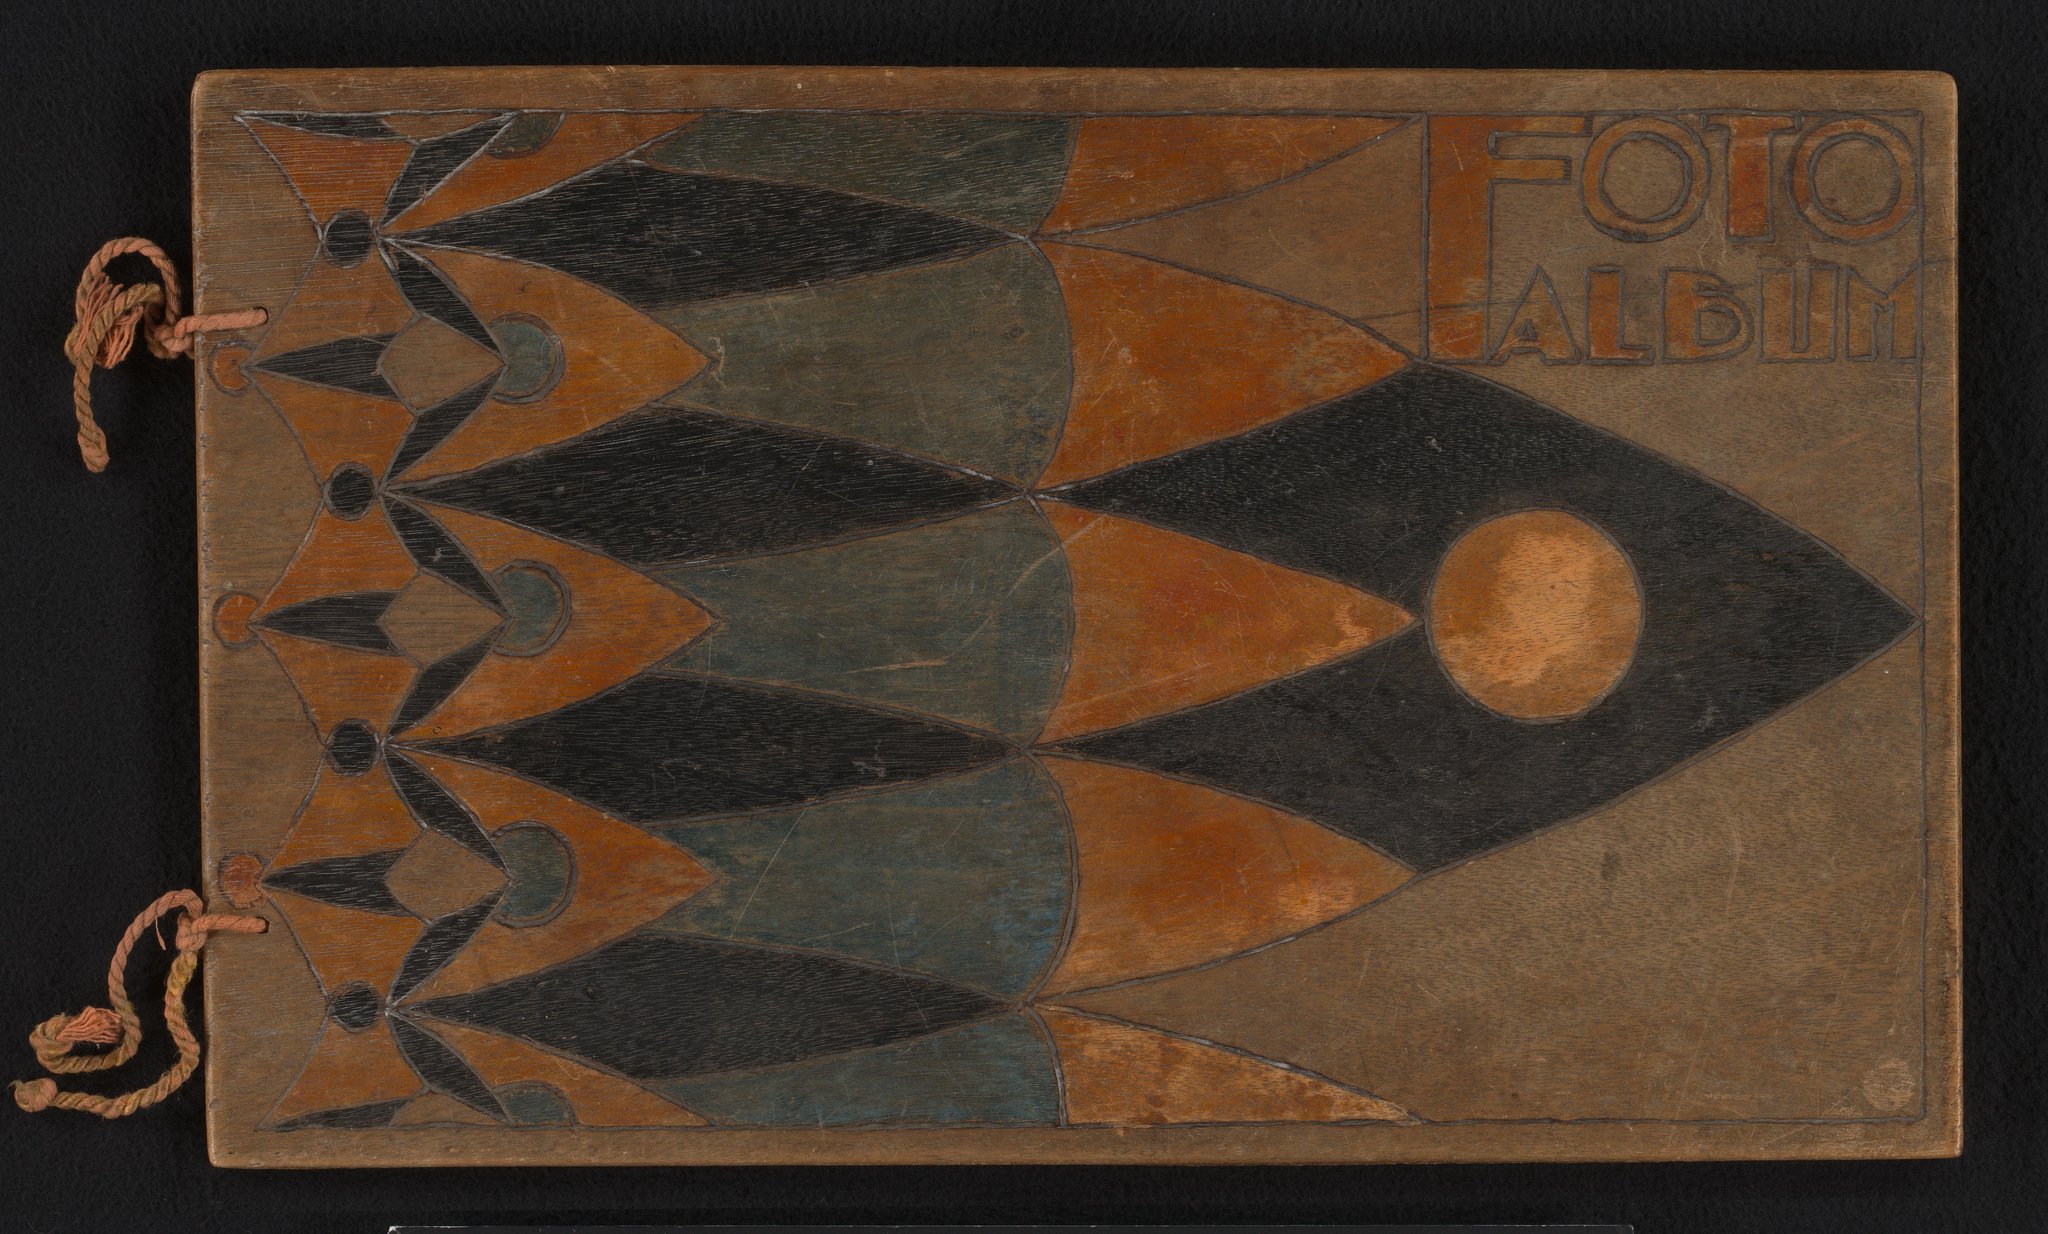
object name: photograph album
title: Voor- en achterplat (in hout) van een fotoalbum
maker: b. rutgers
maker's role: designer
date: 1930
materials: paint, wood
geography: vught